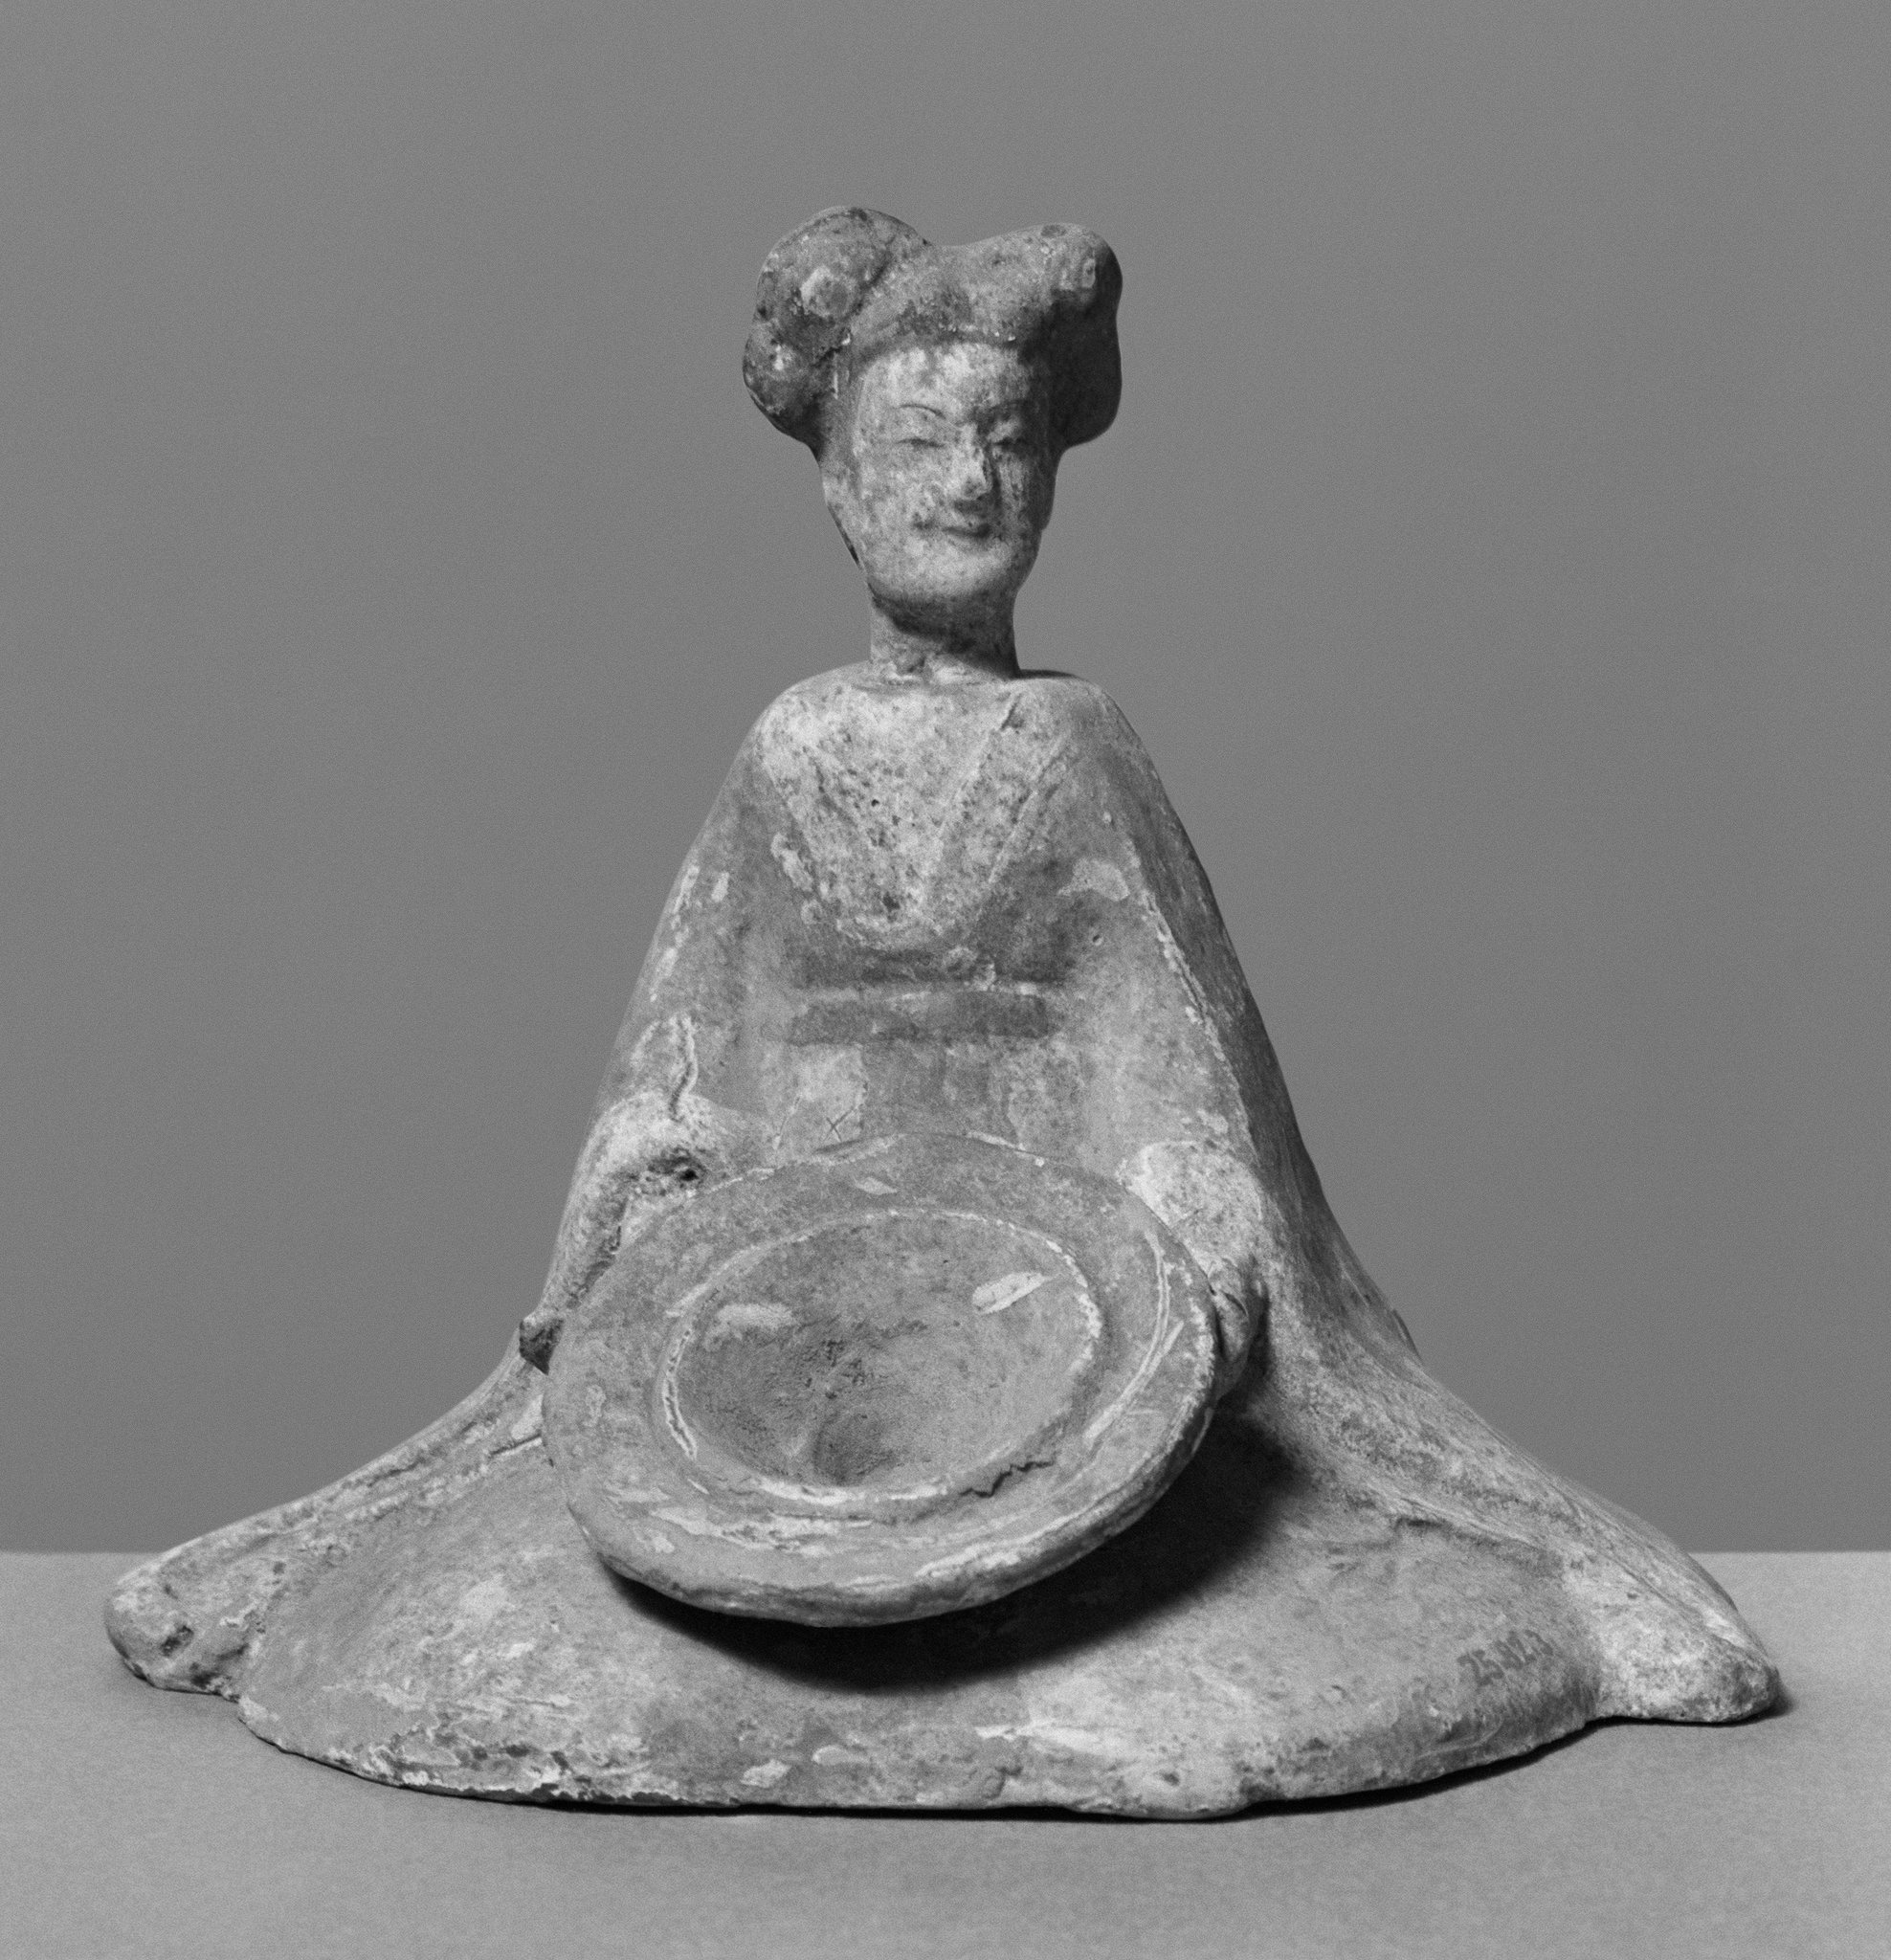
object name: figure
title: Female musician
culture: chinese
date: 501-700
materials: earthenware, pigment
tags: women